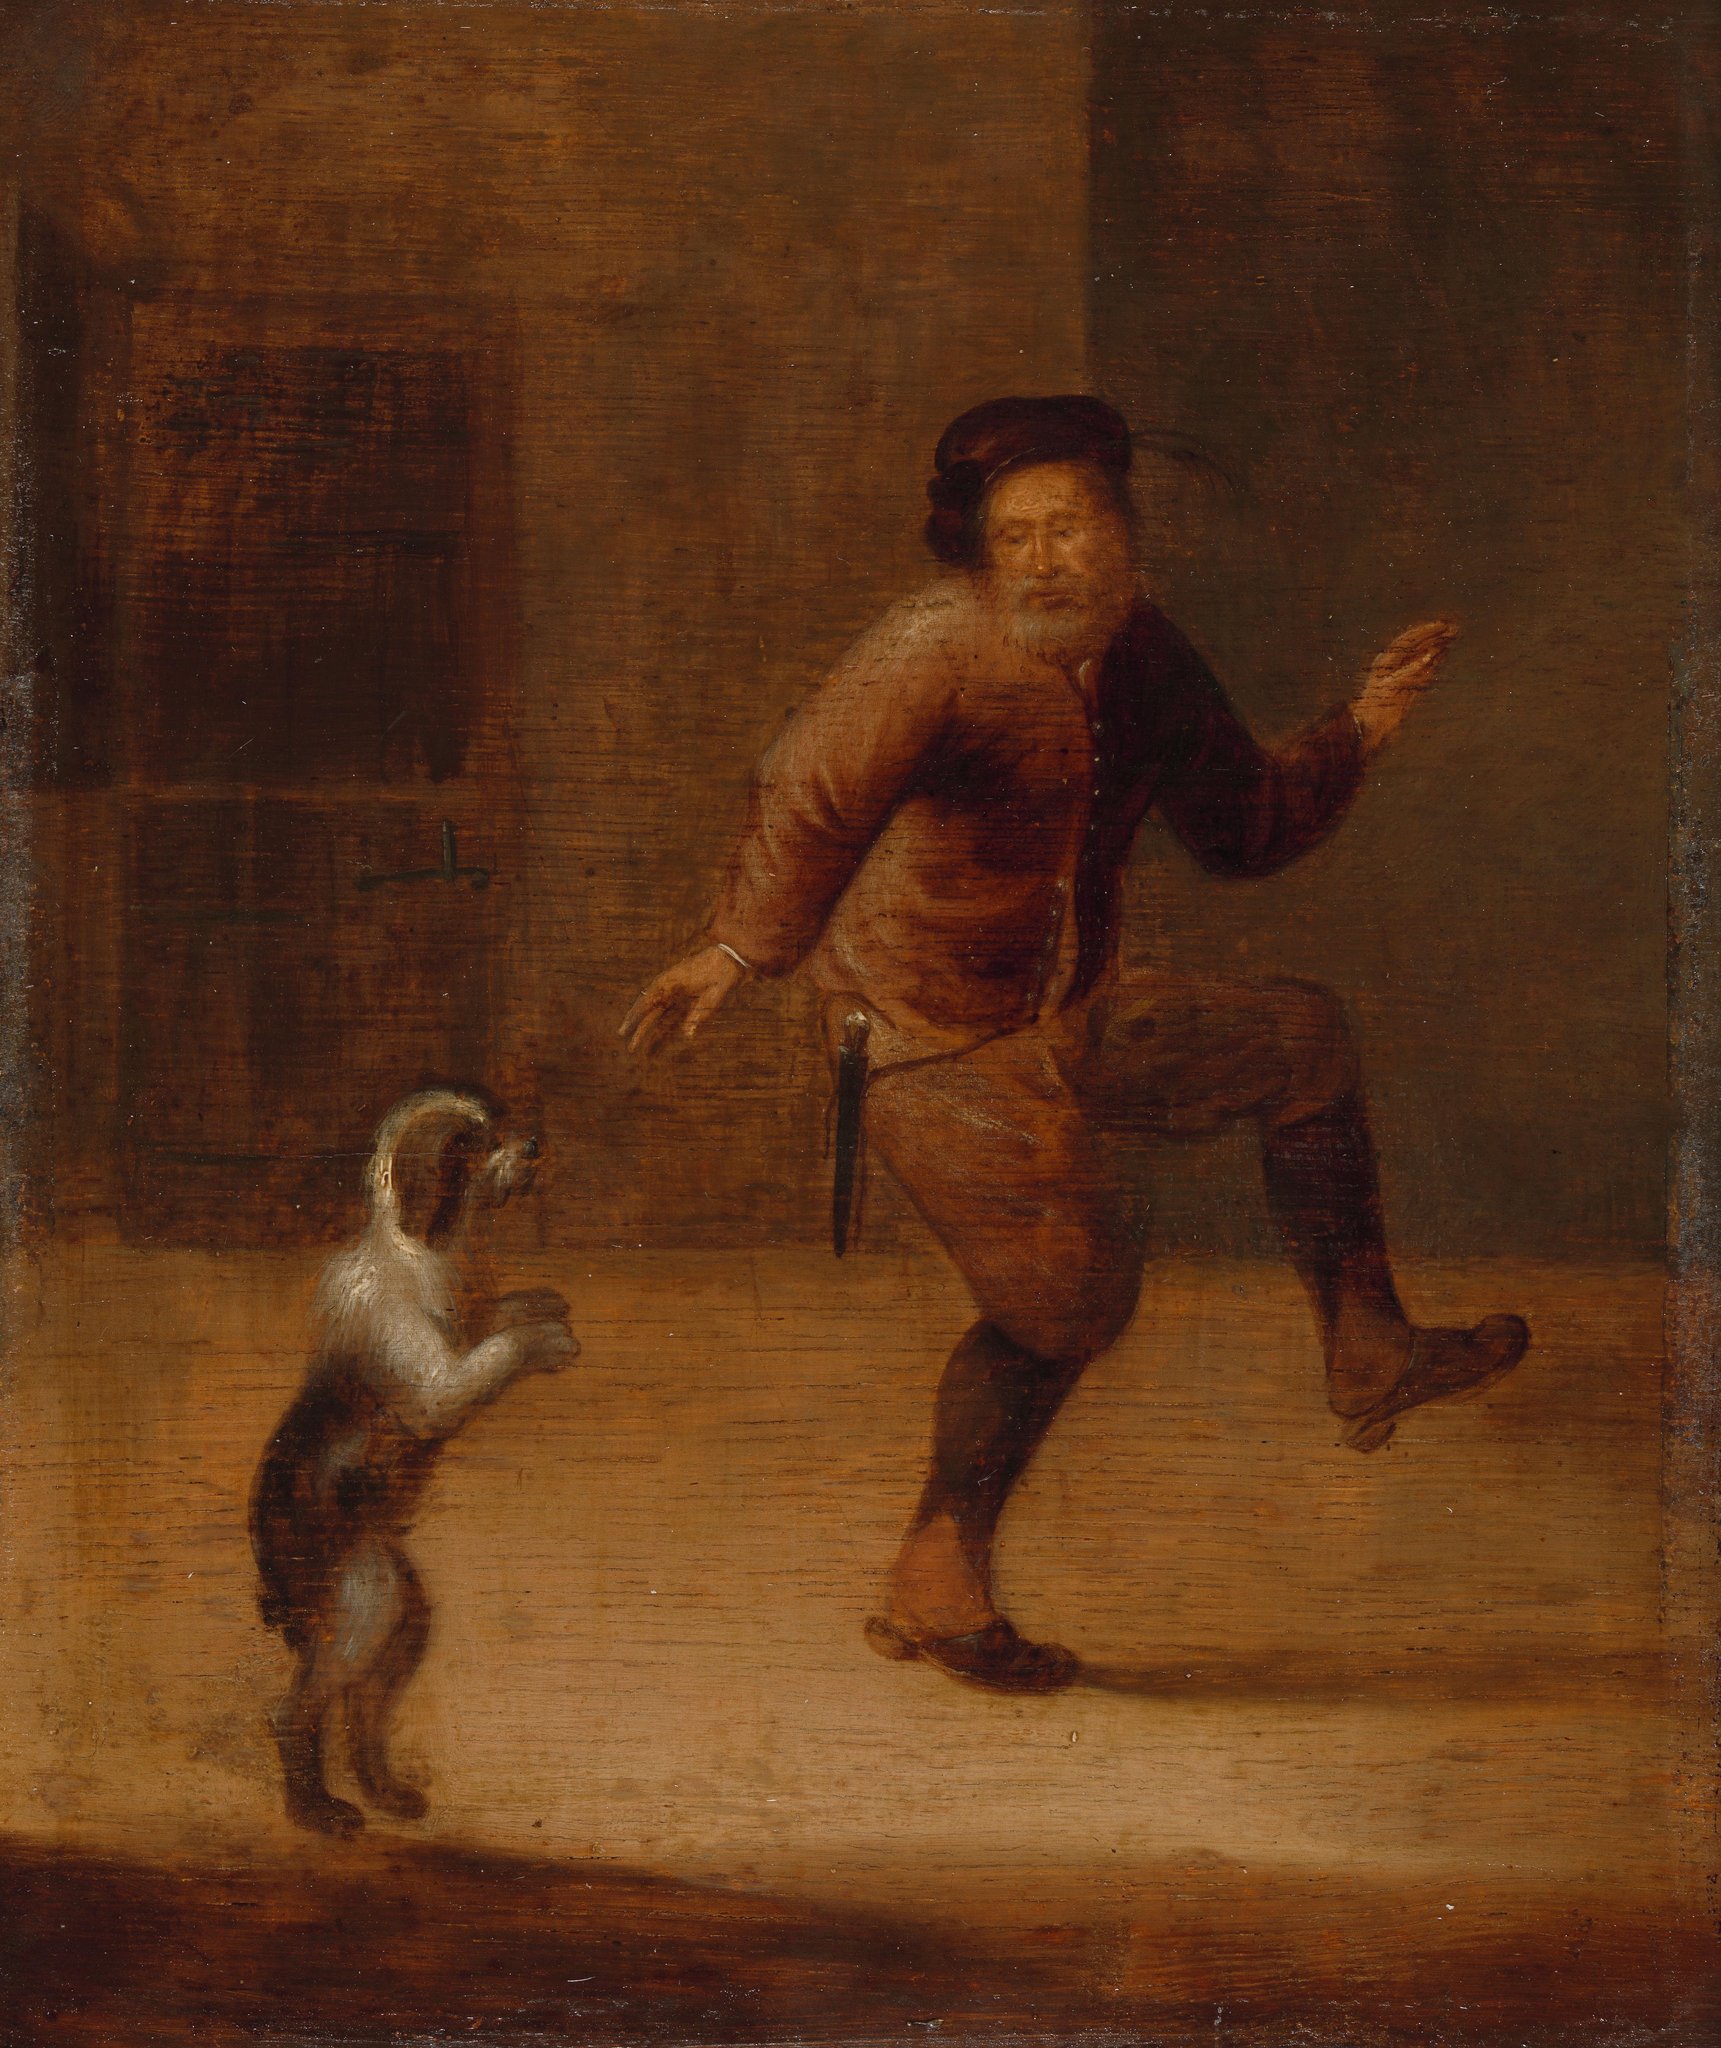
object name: painting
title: A Man Dancing with a Dog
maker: hendrick bogaert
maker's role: painter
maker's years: 1626-1675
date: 1655-1665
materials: oil, panel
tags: training of performing dog, man dancing alone, dog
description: Een man met een baard dansend met een hond.